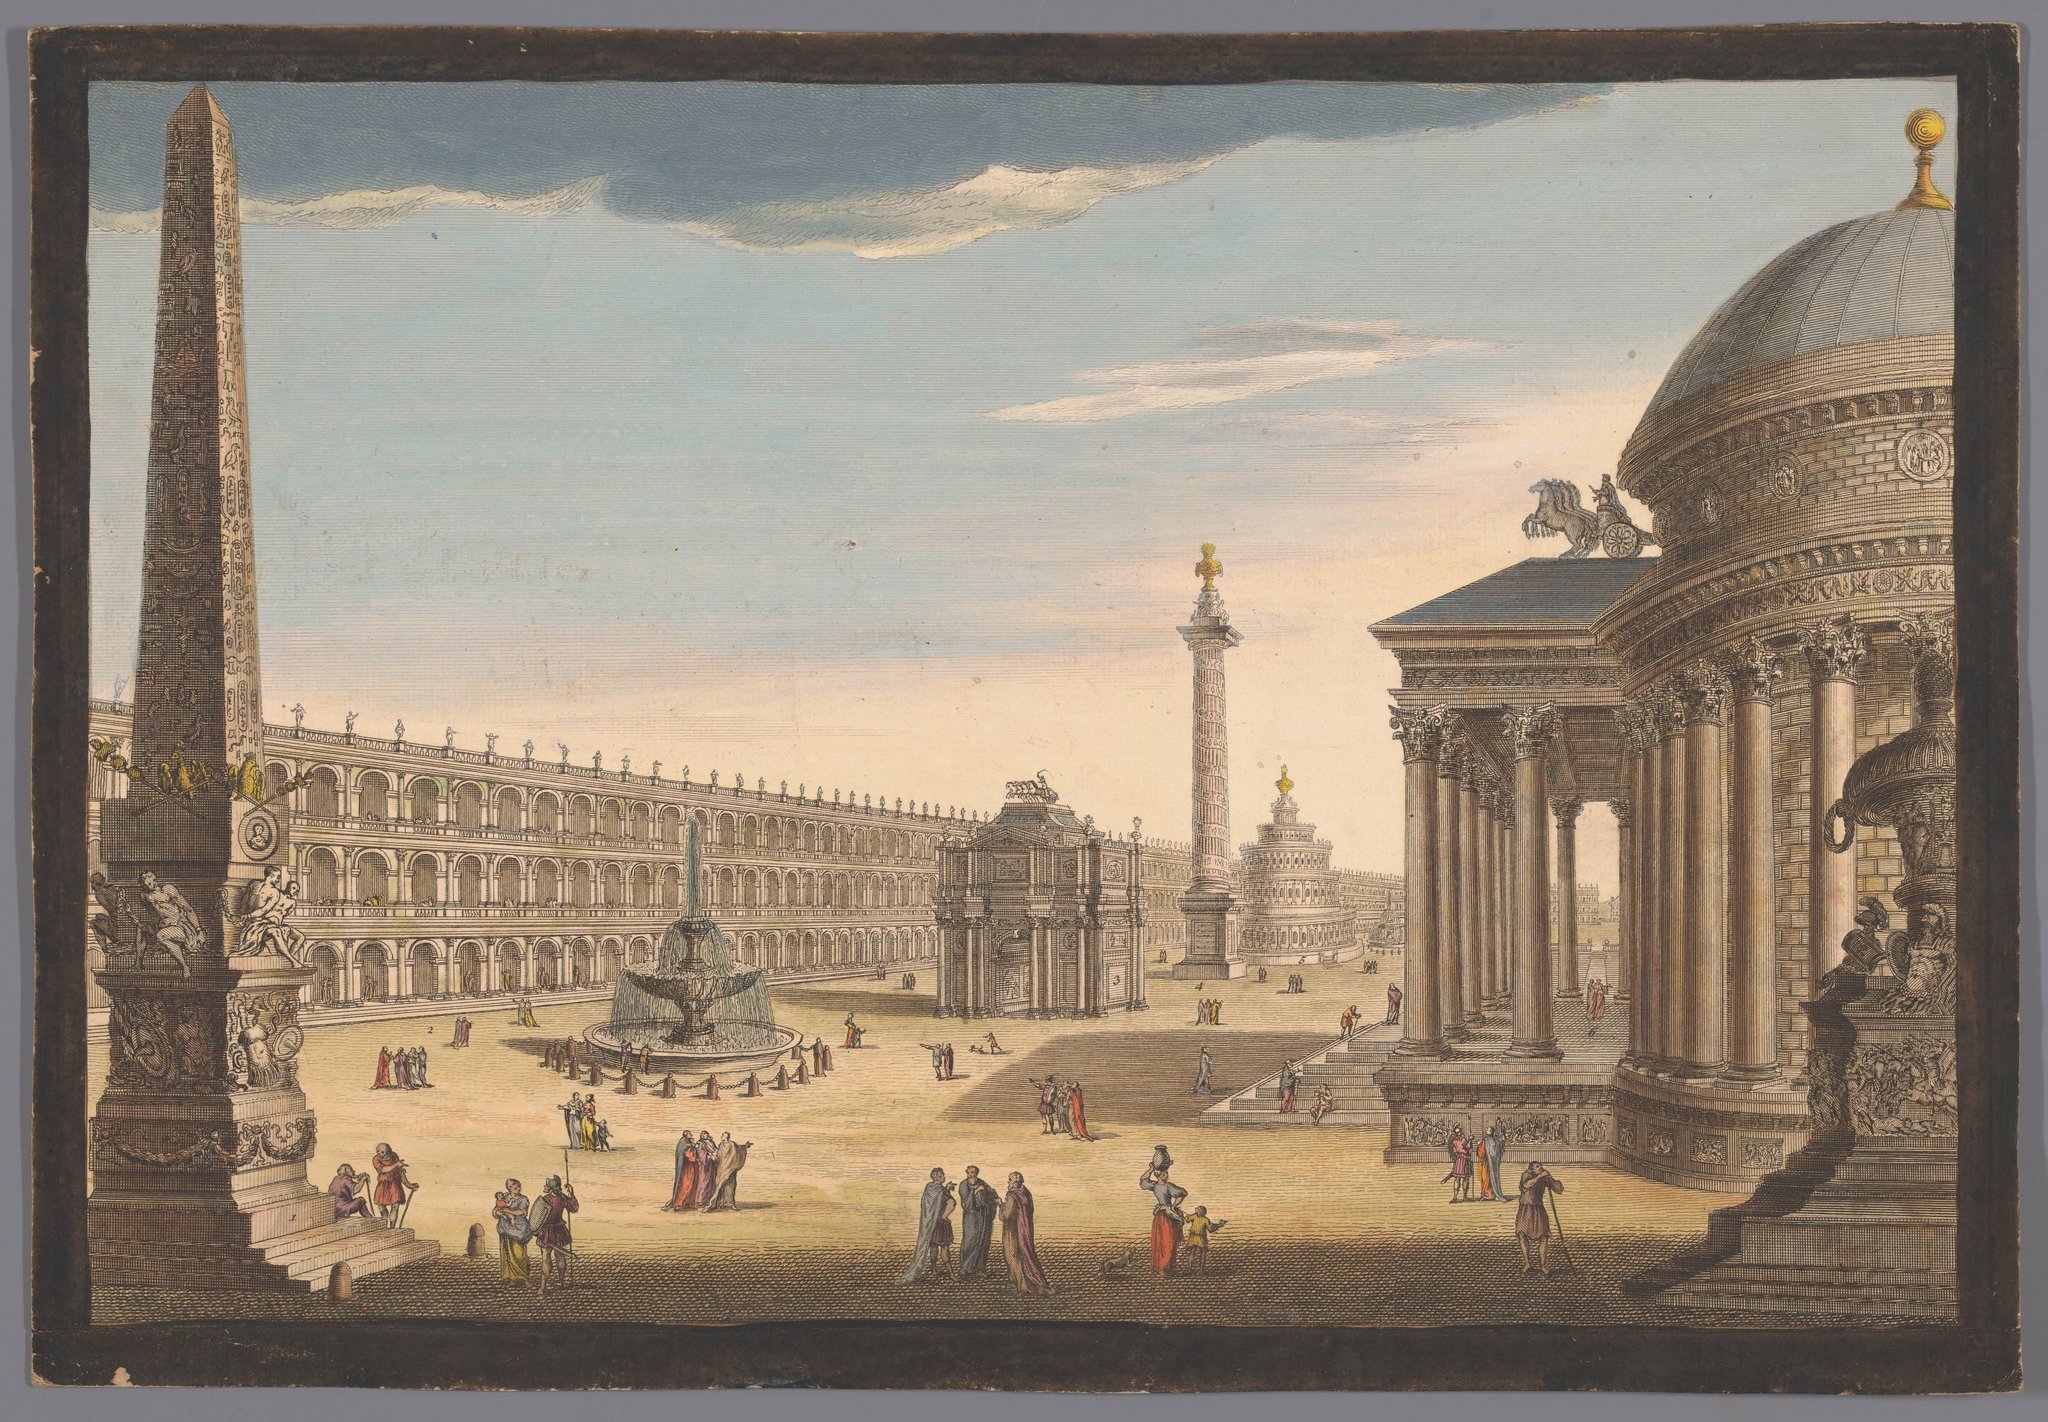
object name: print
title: Rome in it's original splendor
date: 1756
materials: cardboard, paper, watercolor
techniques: brush, etching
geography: london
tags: obelisk, needle (+ city(-scape) with figures, staffage), column (marking grave), triumphal arch, temple, shrine ~ roman religion, rome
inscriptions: collector's mark: Lugt 2233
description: In de ondermarge een verklarende lijst met nummers.